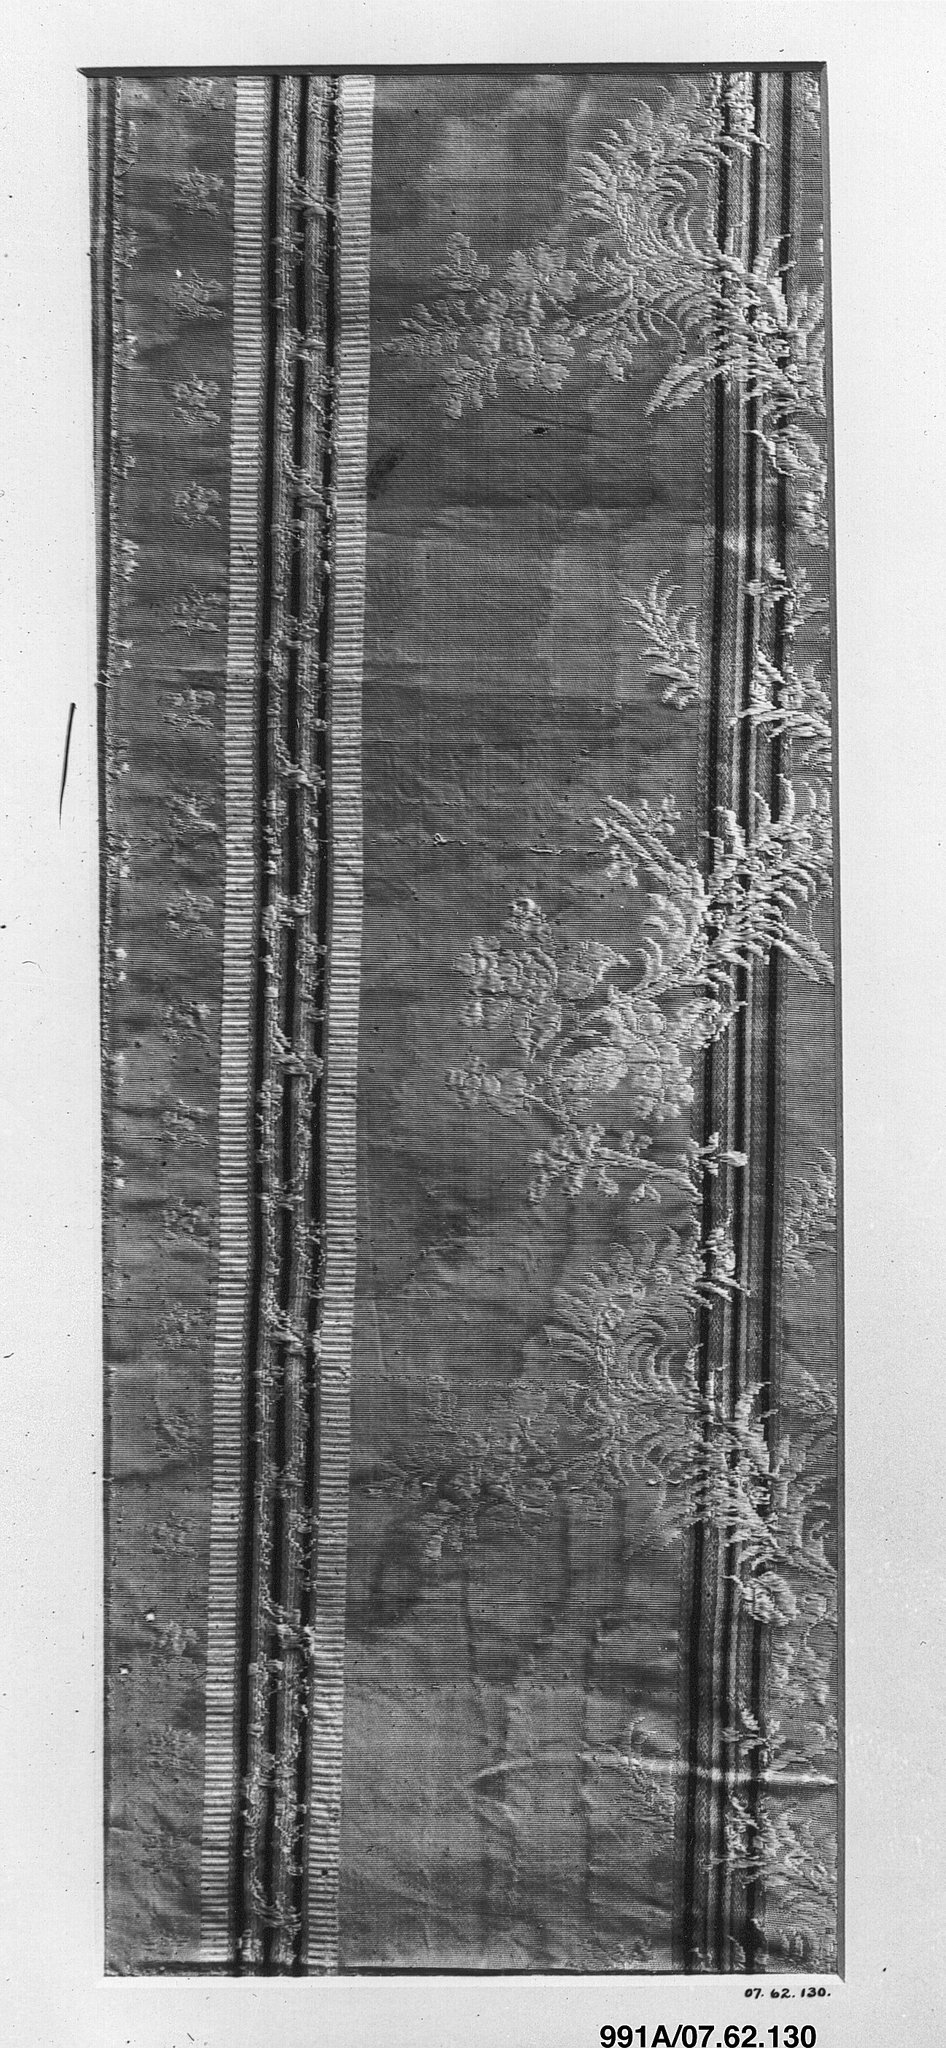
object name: piece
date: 1701-1800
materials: silk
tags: flowers,leaves